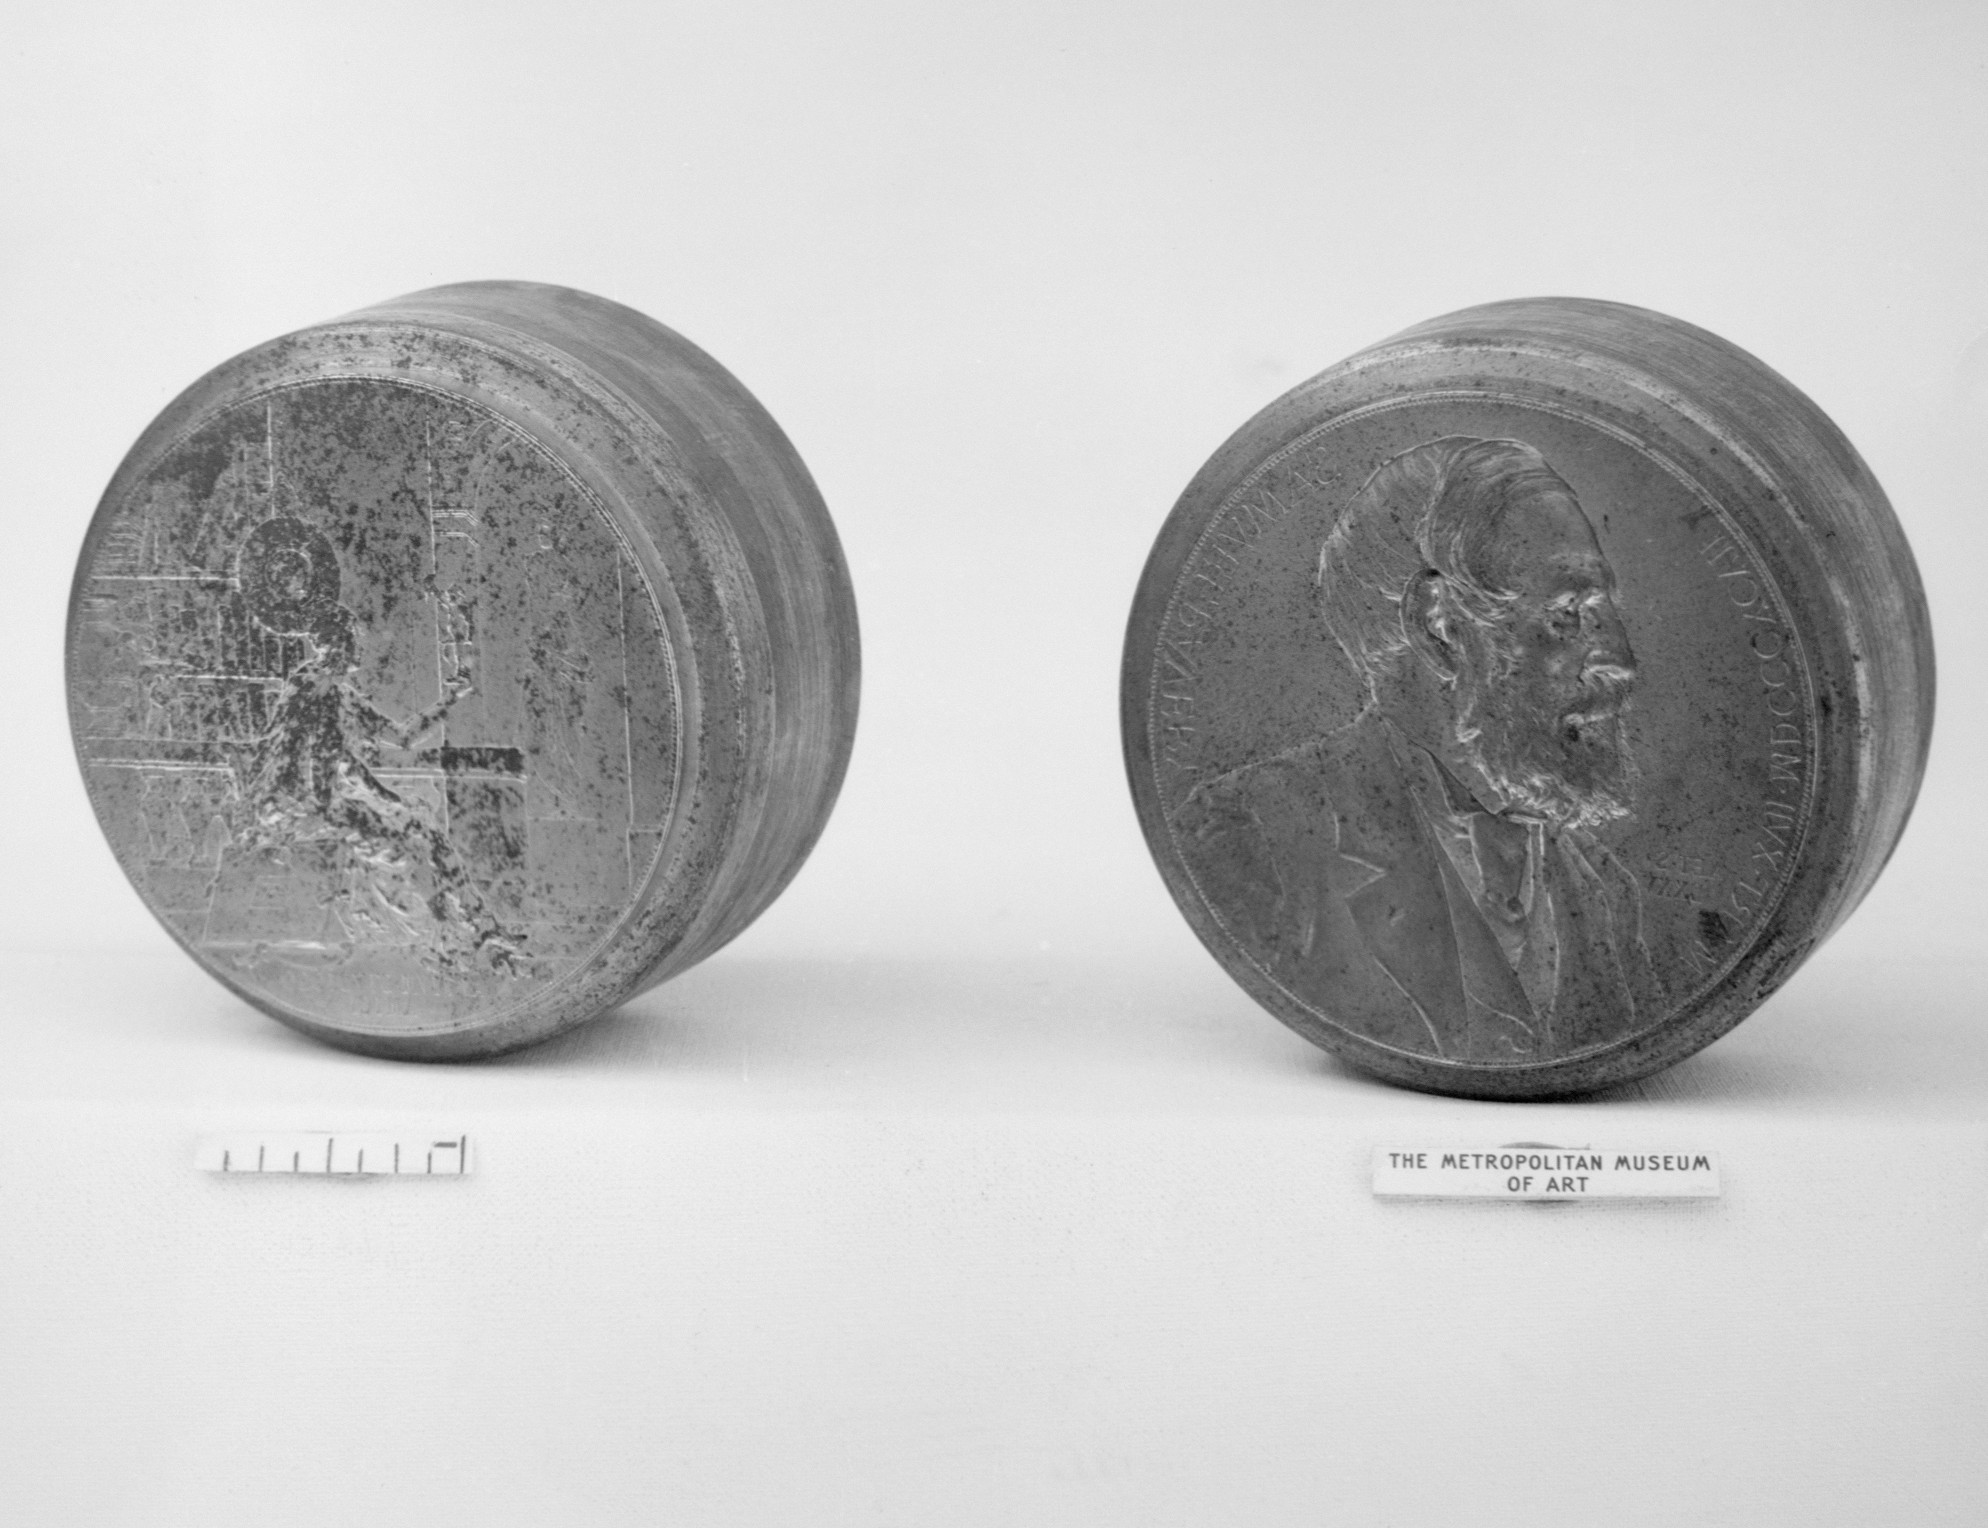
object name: die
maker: anton scharff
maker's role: artist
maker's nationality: austrian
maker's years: 1845-1903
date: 1897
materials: steel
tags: men,profiles